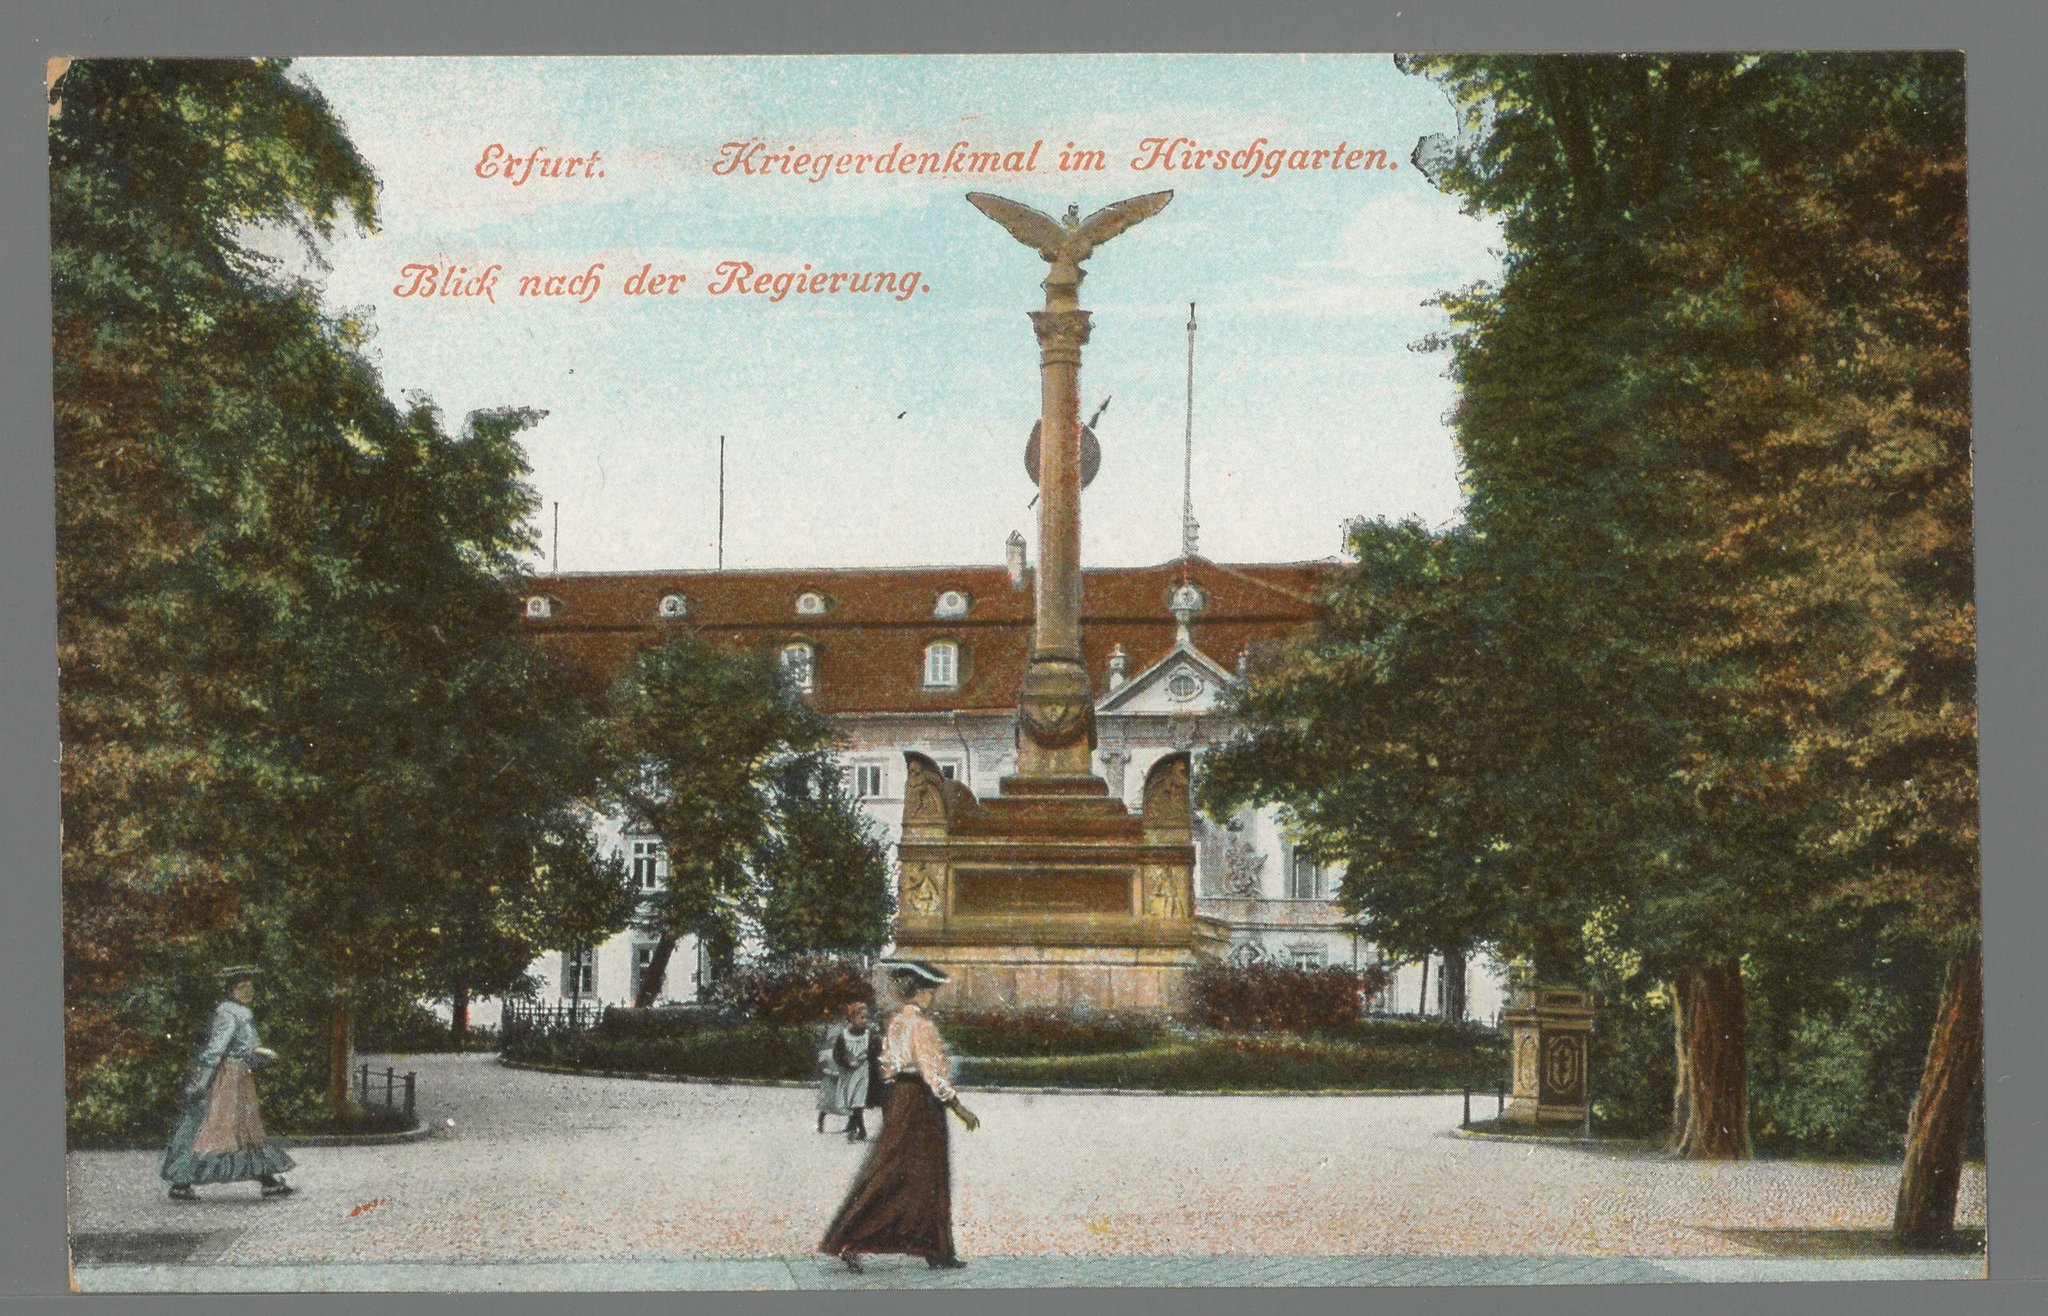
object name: ansichtkaart, prentbriefkaart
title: Erfurt. Kriegerdenkmal im Hirschgarten. Blick nach der Regierung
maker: Anonymous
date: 1905-1930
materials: cardboard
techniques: lithograph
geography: leipzig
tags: monument, statue